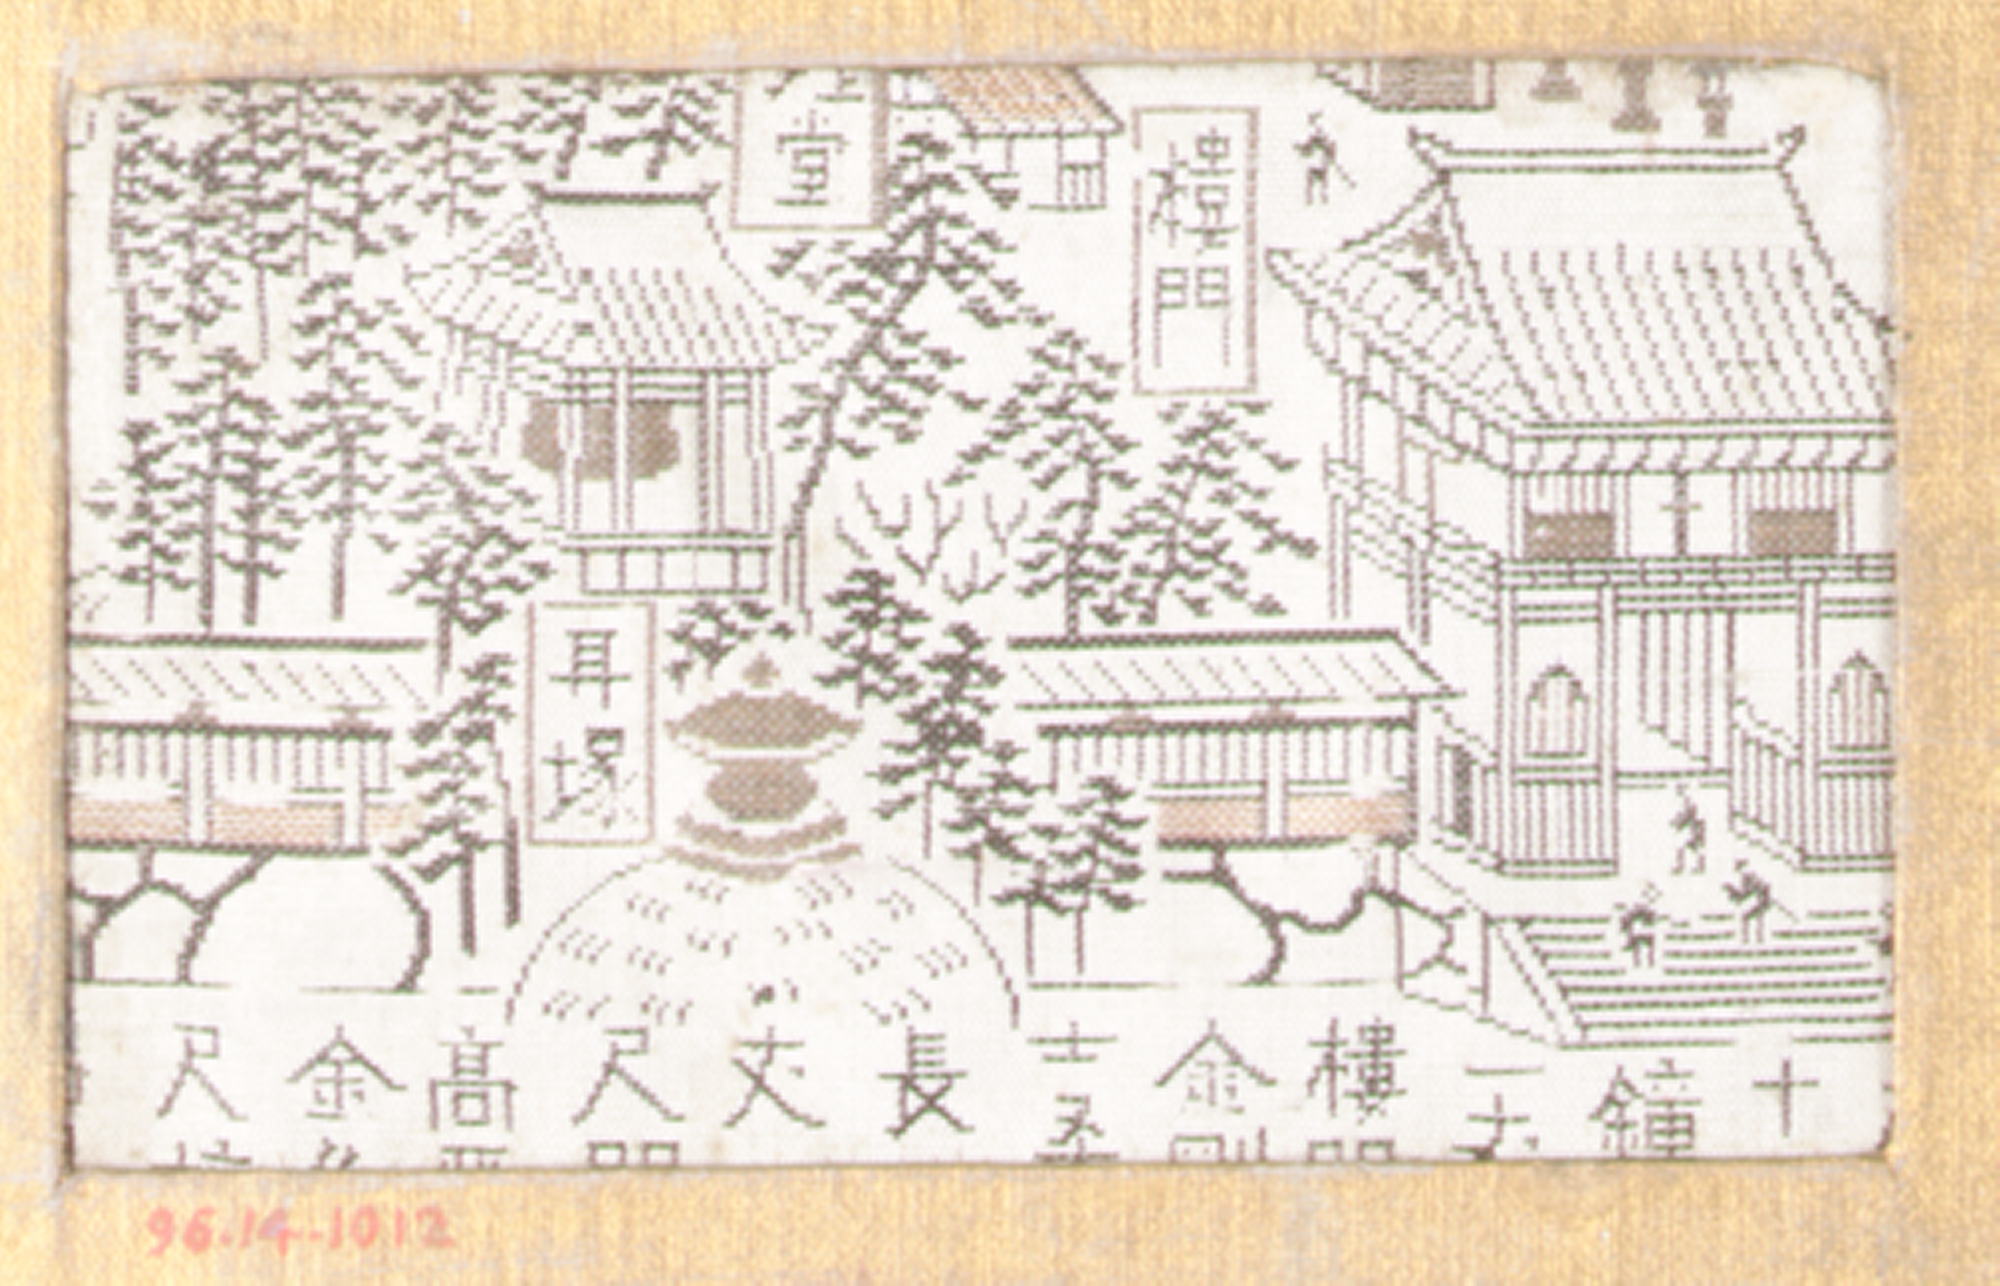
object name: piece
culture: japanese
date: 1701-1900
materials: silk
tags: buildings